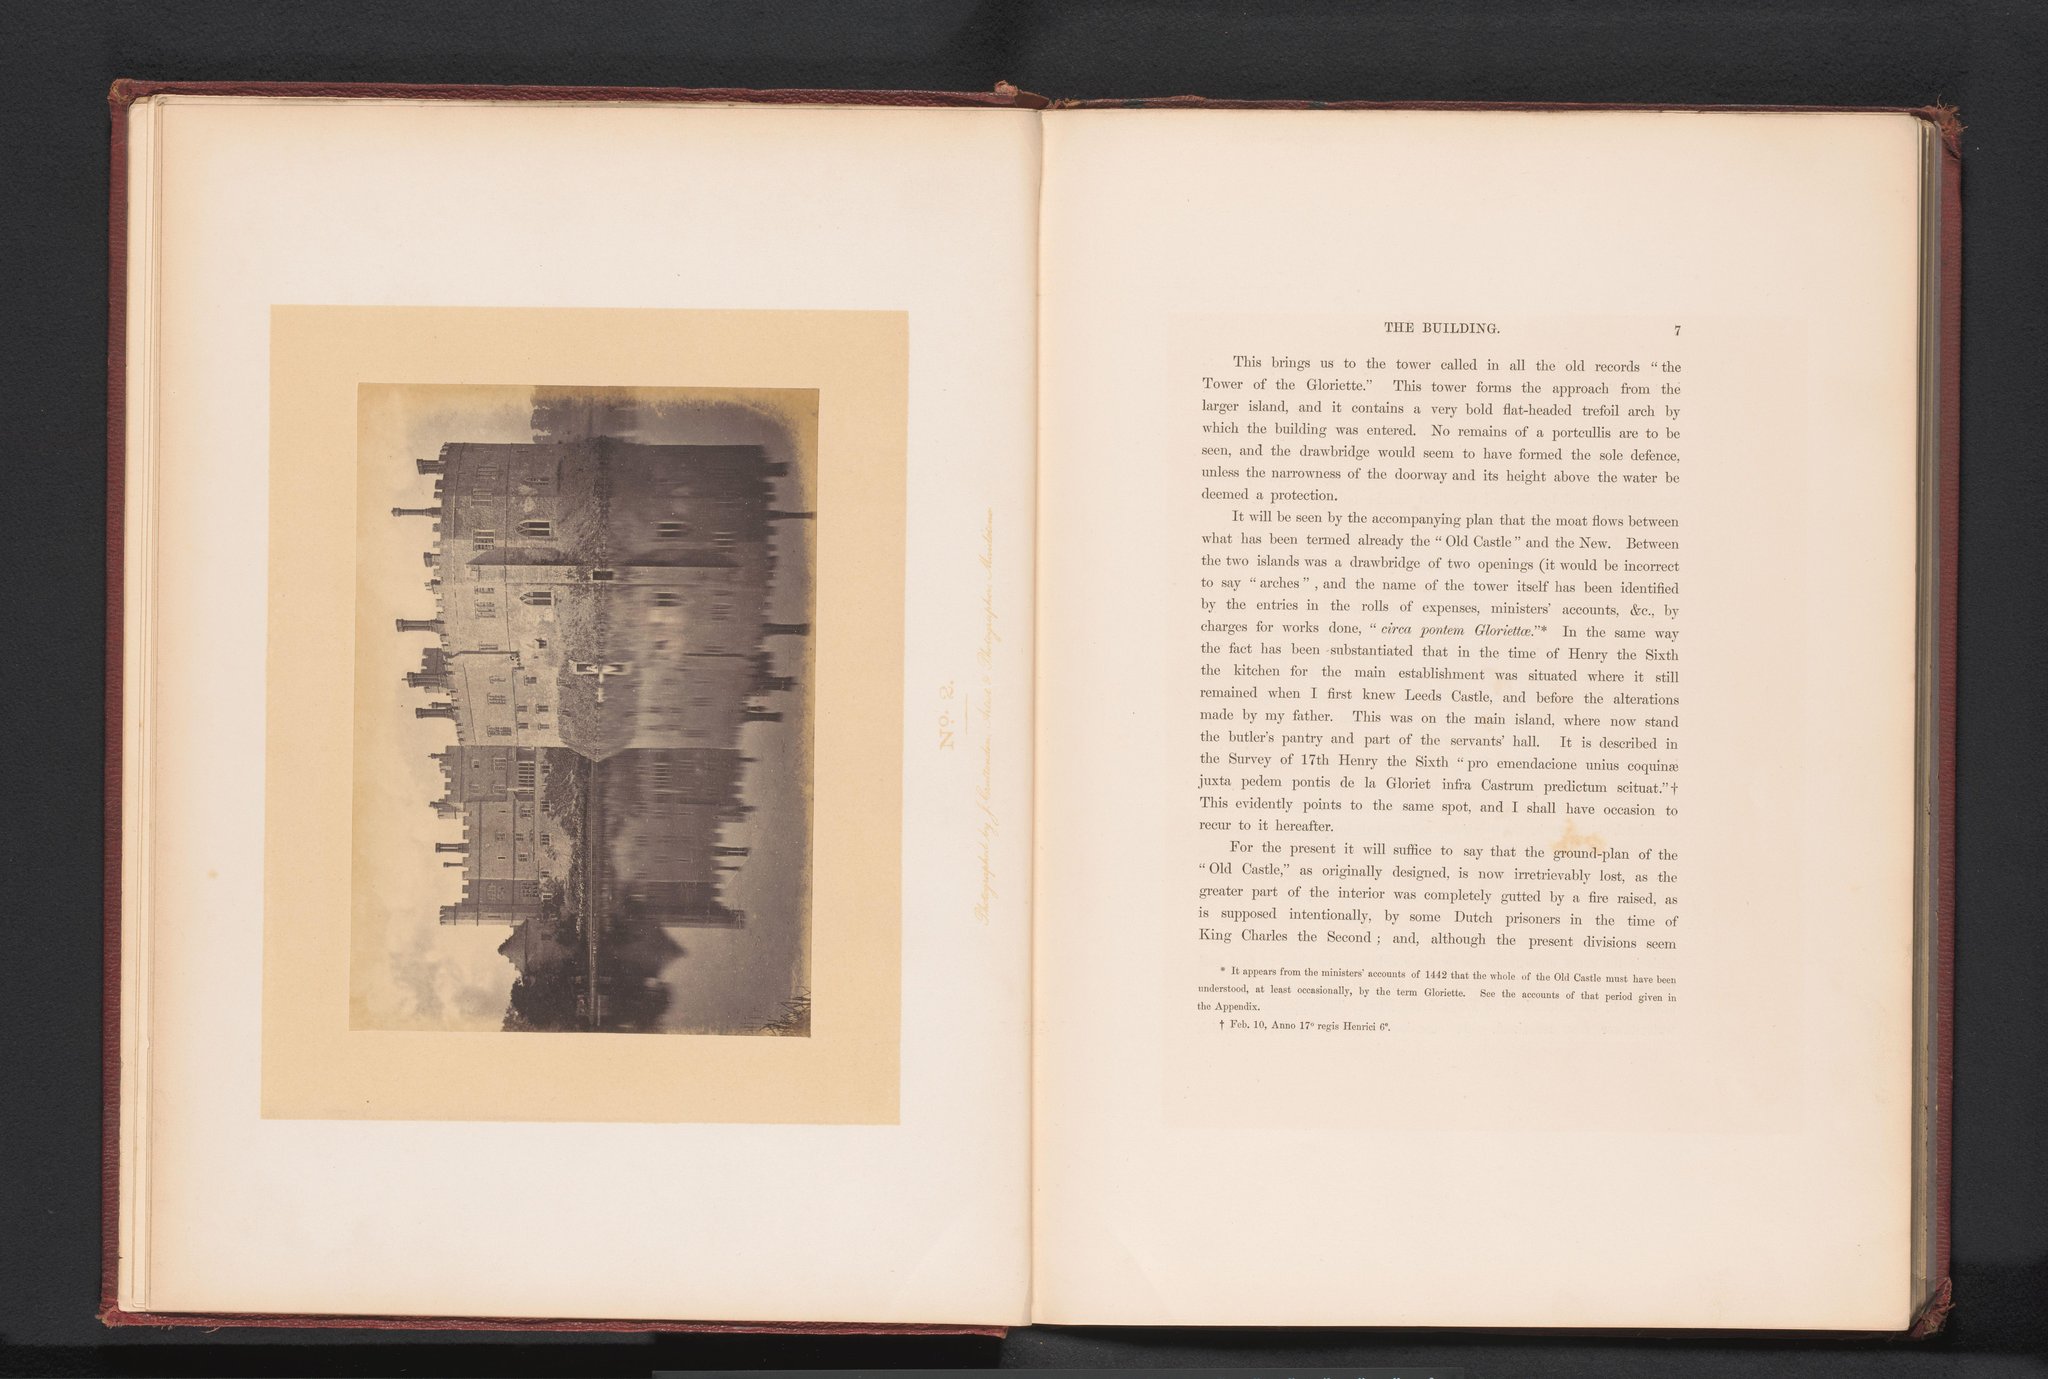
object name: page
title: Oostzijde van Leeds Castle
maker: john cruttenden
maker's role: fotograaf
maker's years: 1825-1892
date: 1864-1869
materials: photographic support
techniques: albumen print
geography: leeds castle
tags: castle, landscape with tower or castle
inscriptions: inscription: ‘No.2.’